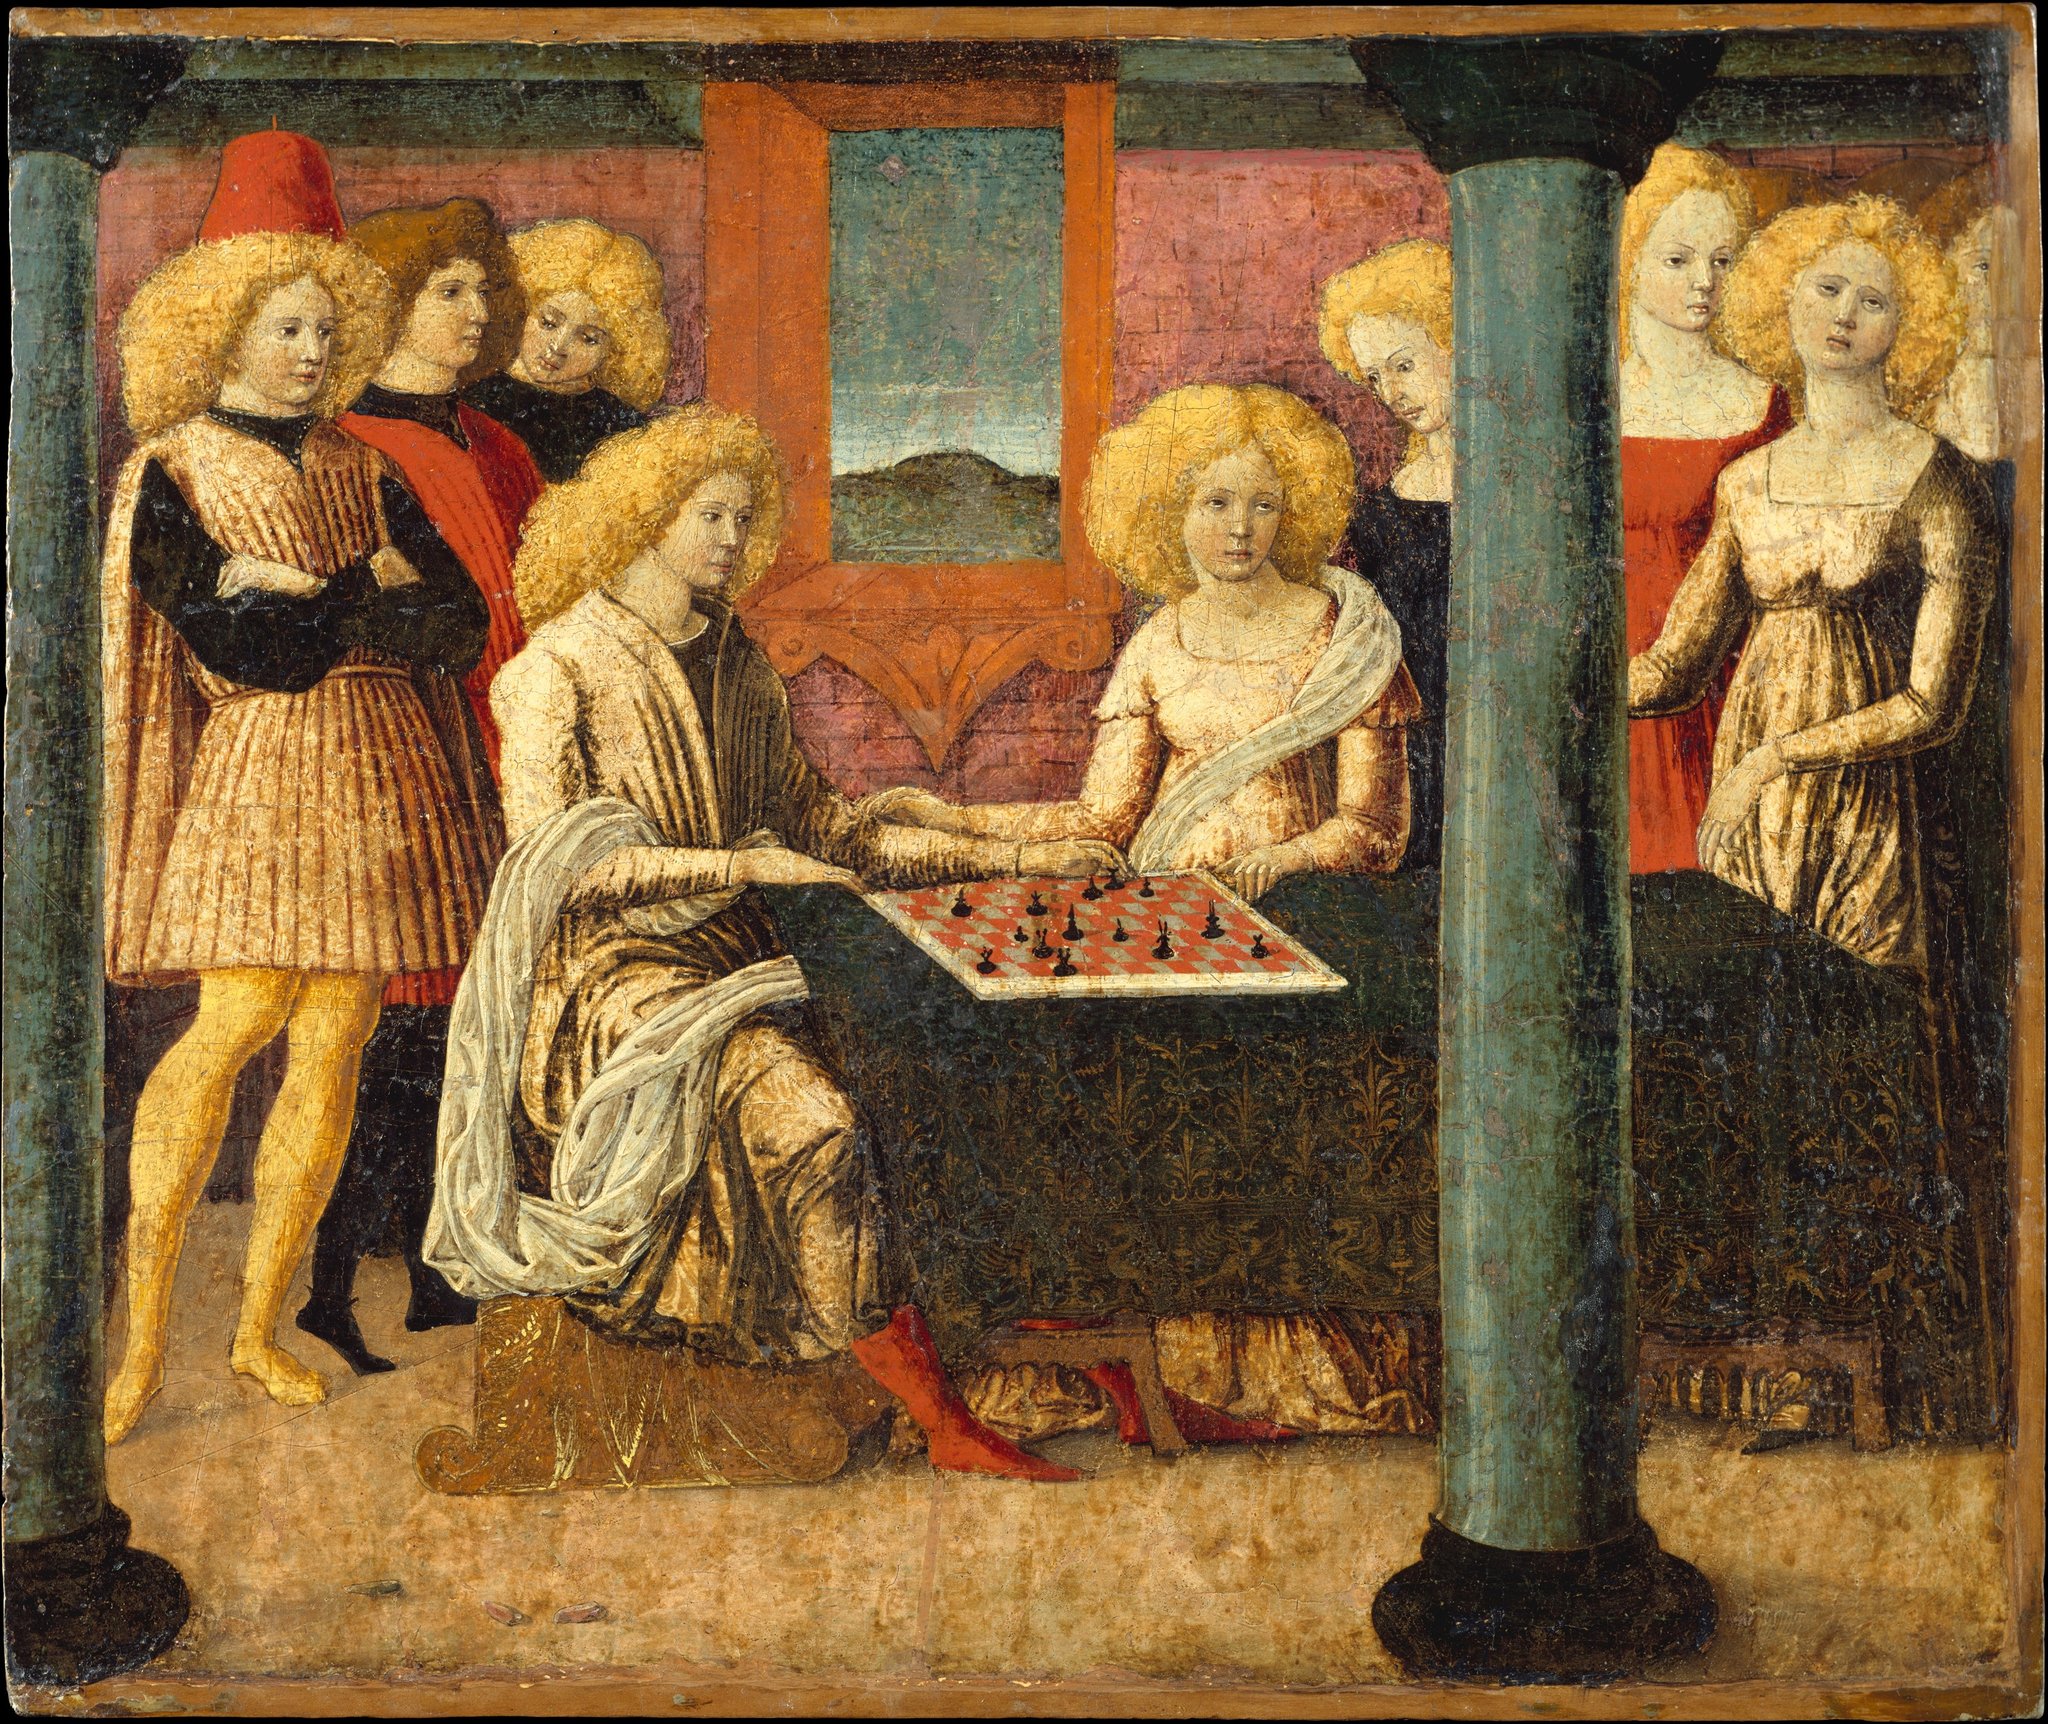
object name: painting, cassone panel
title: The Chess Players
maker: liberale da verona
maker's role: artist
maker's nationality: italian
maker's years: 1445-1529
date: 1475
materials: paint, wood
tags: men,women,chess